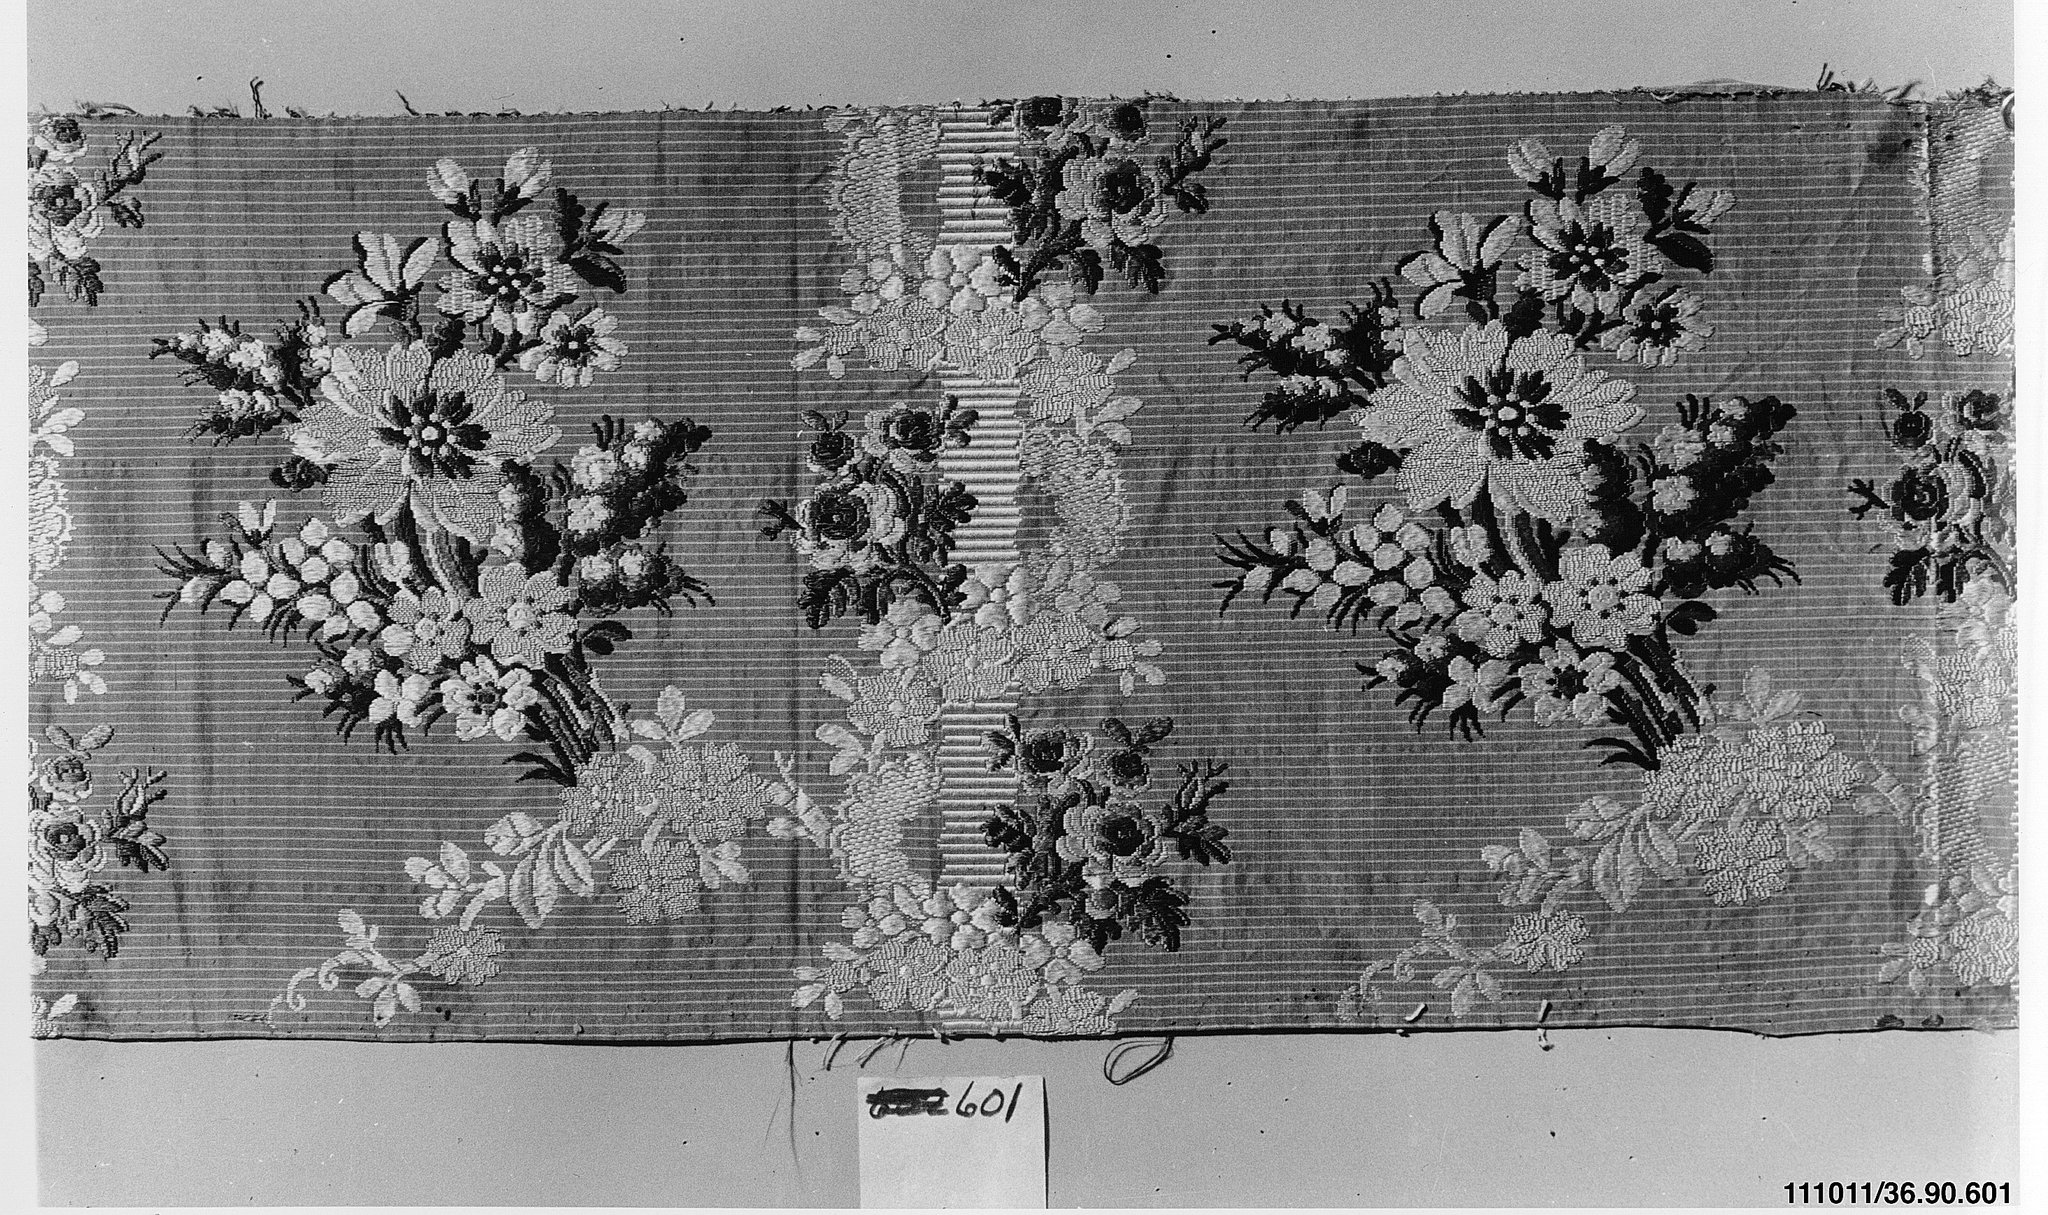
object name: piece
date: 1734-1766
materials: silk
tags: flowers